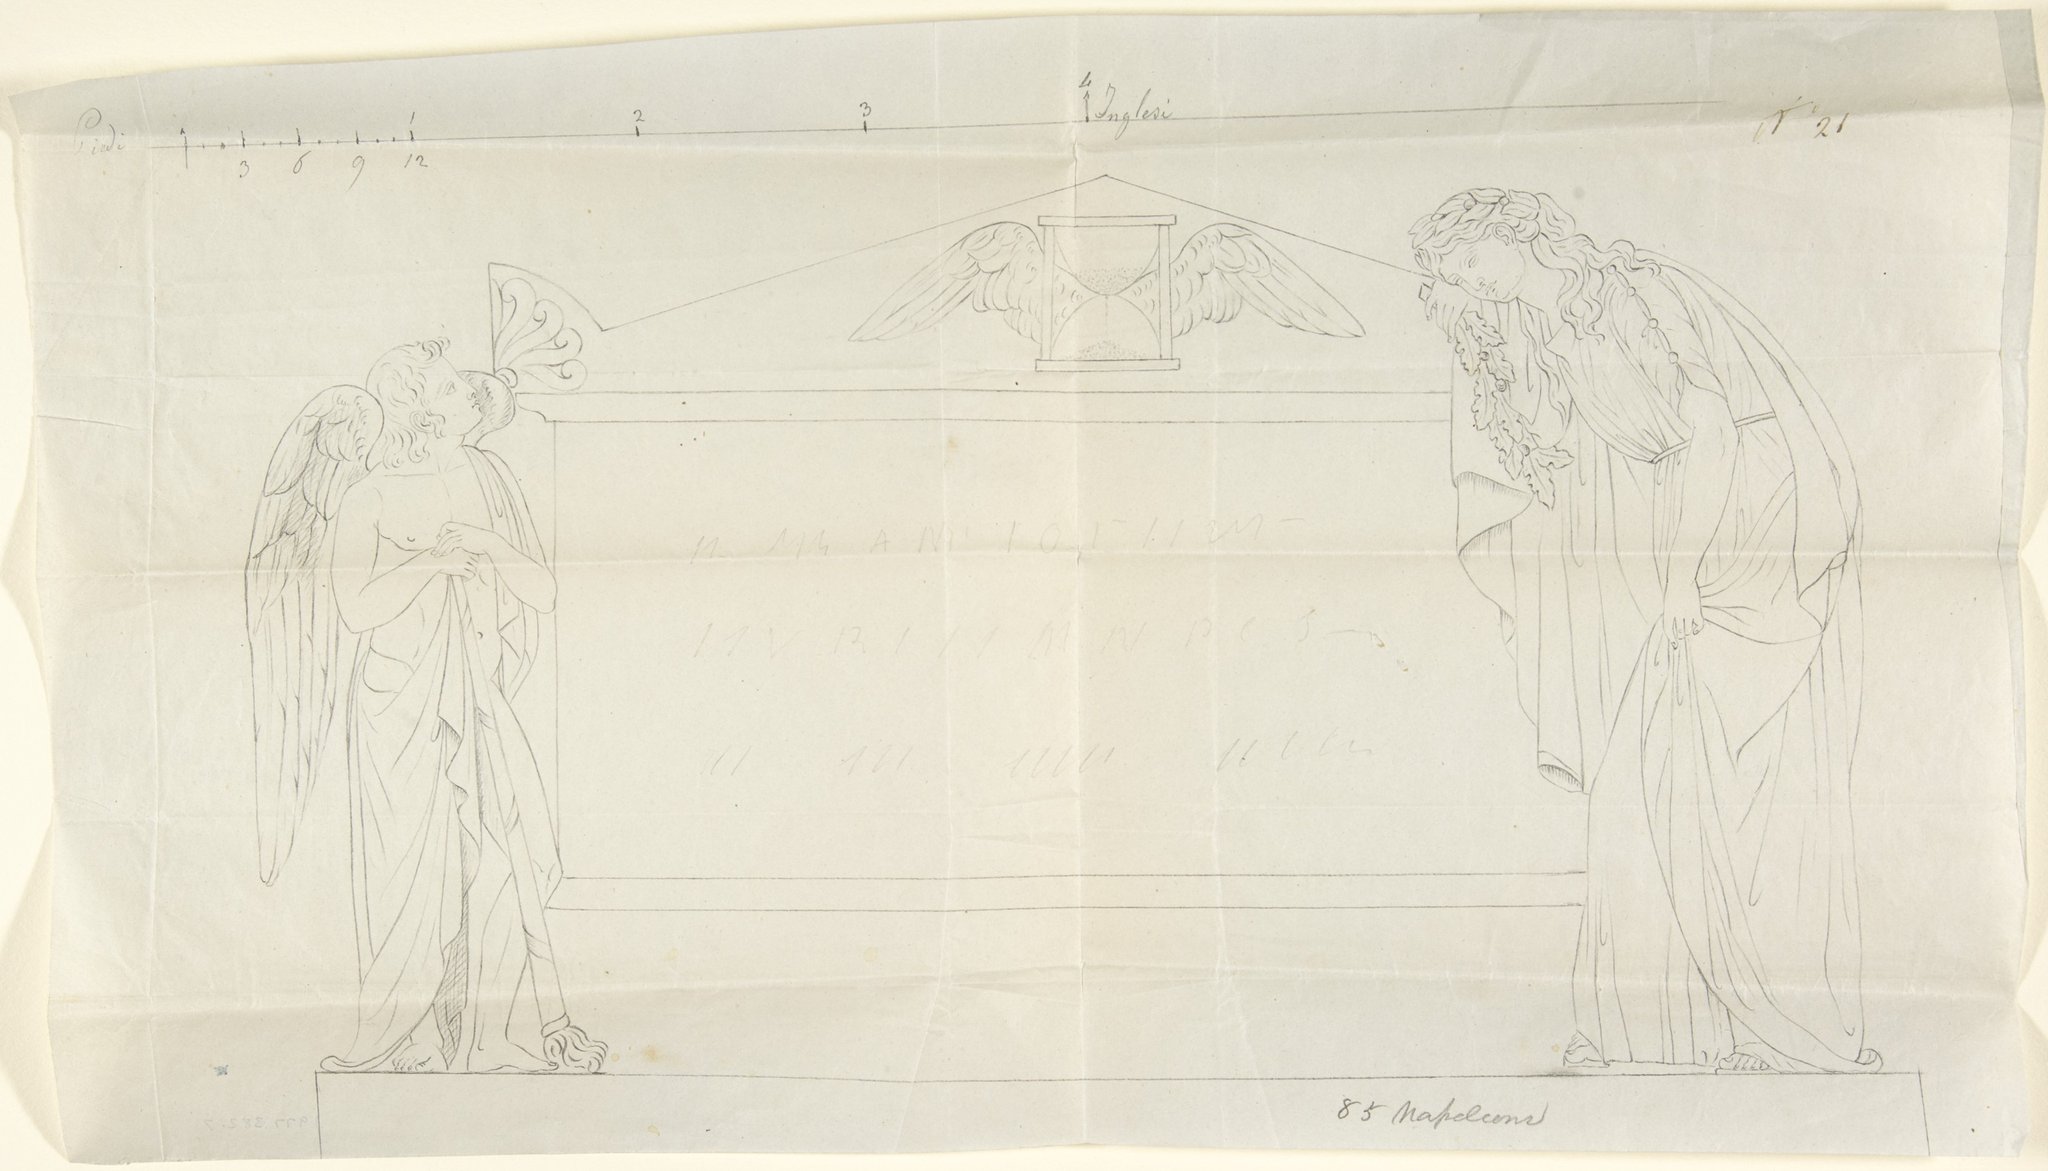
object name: drawing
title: Design for a sarcophagus with two mourning figures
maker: john gibson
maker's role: artist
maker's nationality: british, born wales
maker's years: 1790-1866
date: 1850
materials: graphite, ink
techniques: pen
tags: sadness,women,angels,sarcophagus